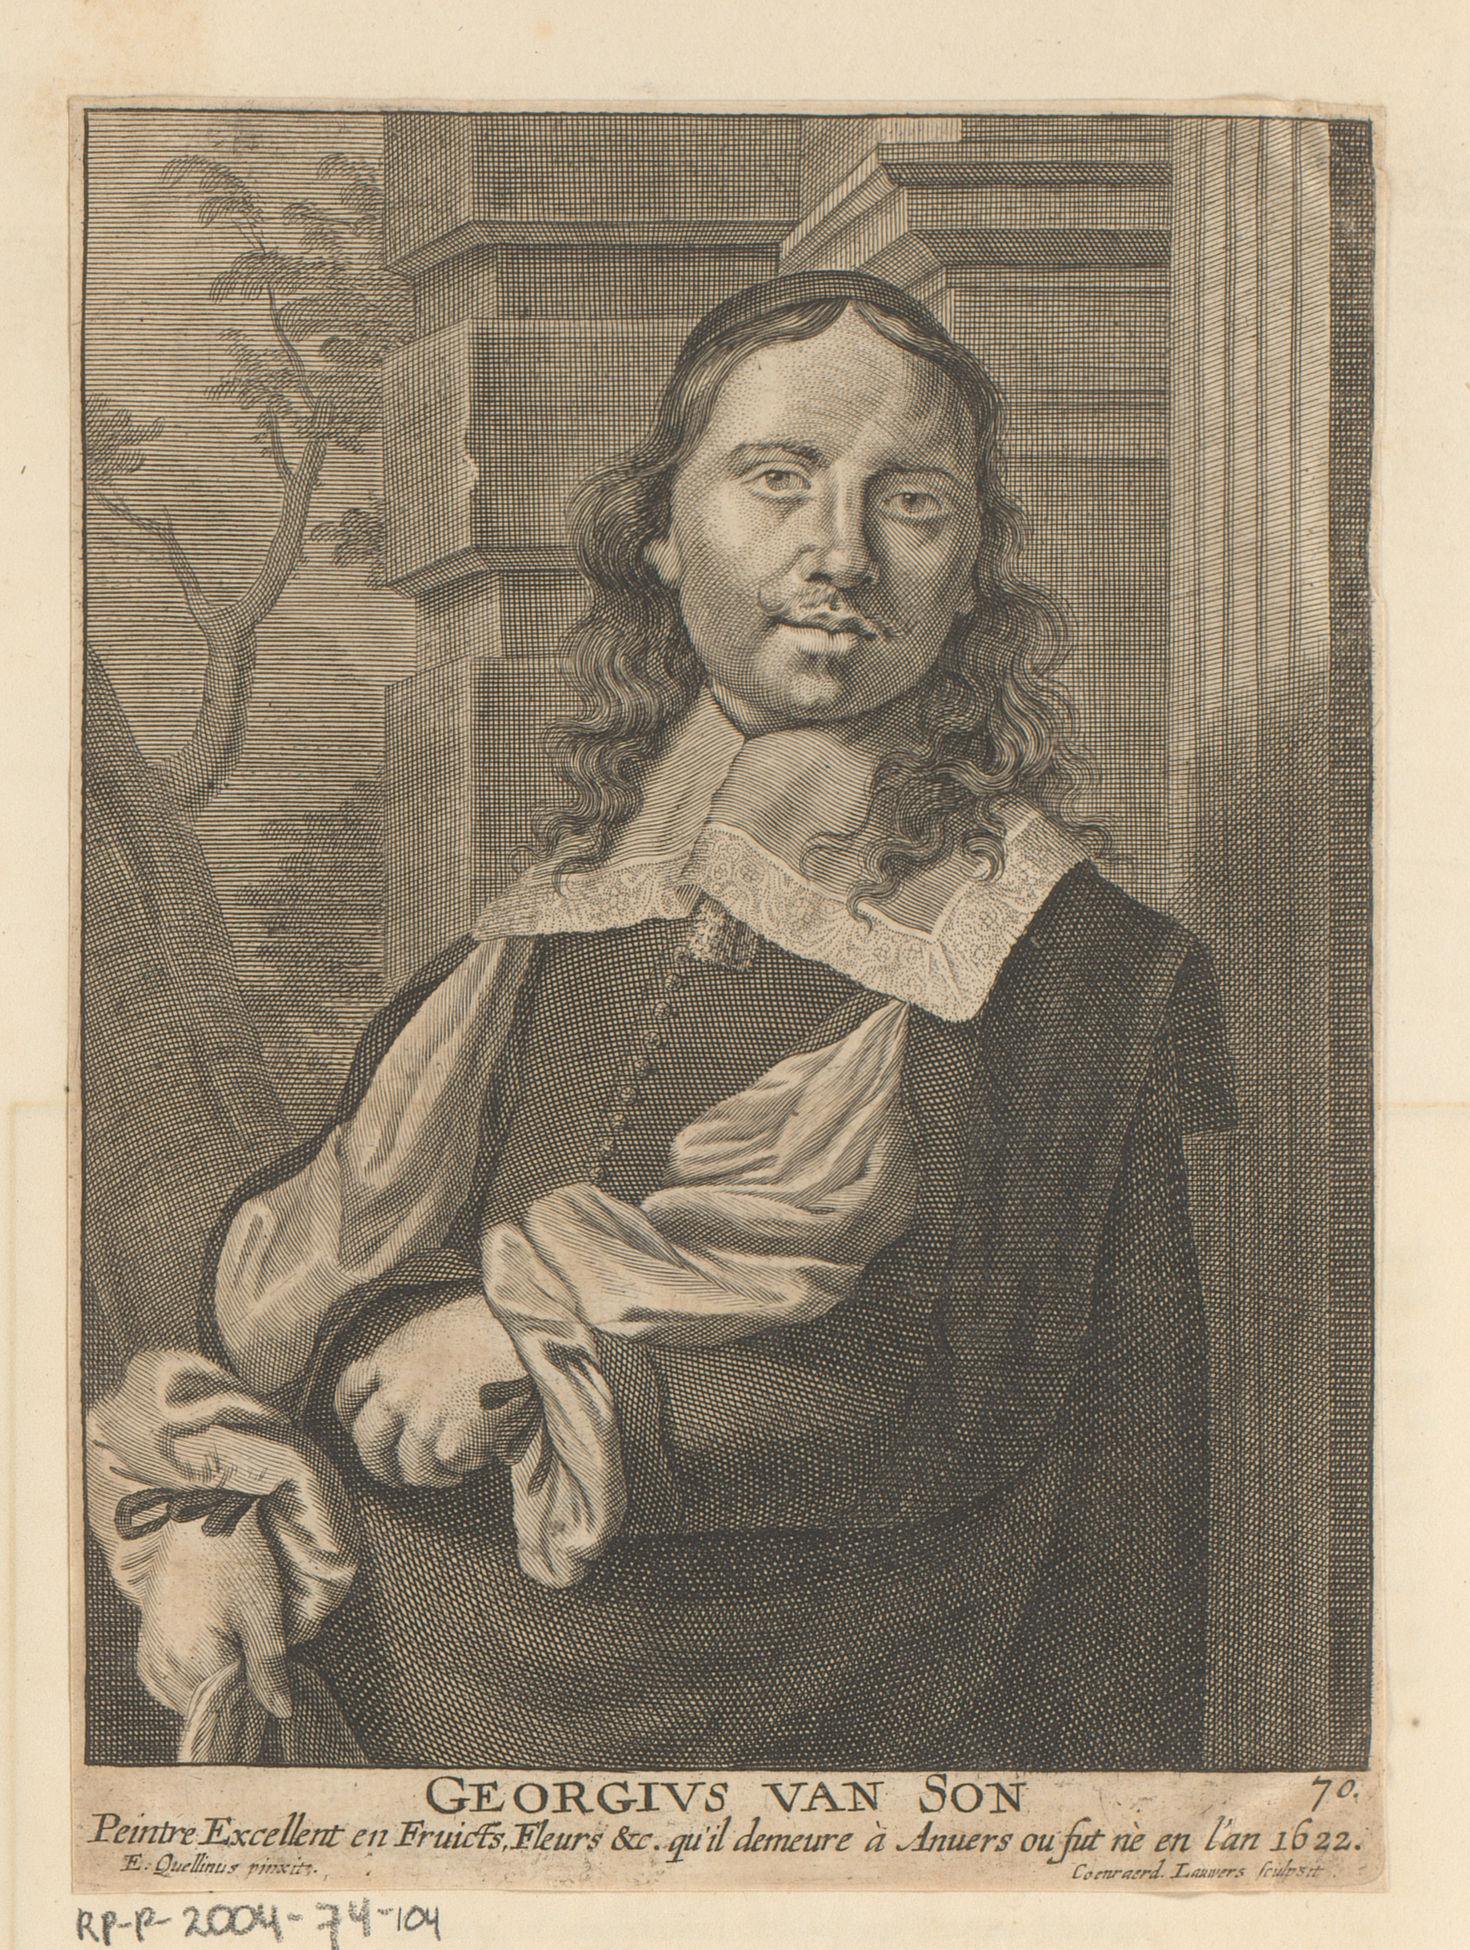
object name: book illustration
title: Portret van Joris van Son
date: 1649-1662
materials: paper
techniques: engraving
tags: painter, joris van son, historical persons, portrait, self-portrait of painter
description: Huidige staat van prent (genummerd 70) gebruikt in: The Portraits of the Most Eminent Painters, and other Famous Artists (...). Londen: Olive Payne, 1739. Eerste bekende staat (ongenummerd) gebruikt in: Bie, Cornelis De. Het gulden Cabinet vande edel vry schilder const, inhoudende den lof vande vermarste schilders, architecte, beldthowers ende plaetsnyders van dese eeuw. Antwerpen: Joannes Meyssens, 1662 [1661 foutief op titelpagina], p. 403. En mogelijk ook al in: Meyssens, Joannes. Image de divers hommes desprit sublime qui par leur art et science deburovent vivre eternellement et des quels la louange et renommée faict estonner le monde. 2 dln. Antwerpen: Joannes Meyssens, 1649. Tweede bekende staat (genummerd 91) gebruikt in: Resta, Sebastiano. The true effigies of the most eminent painters and other famous artists that have flourished in Europe. Londen, 1694. De samensteller heeft deze prent in het album geplakt als illustratie bij: Pilkington, Matthew en Johann Heinrich Füssli. A dictionary of painters, from the revival of the art to the present period. 4 dln. Londen: John Crowder, 1805, dl. 3, p. 524.